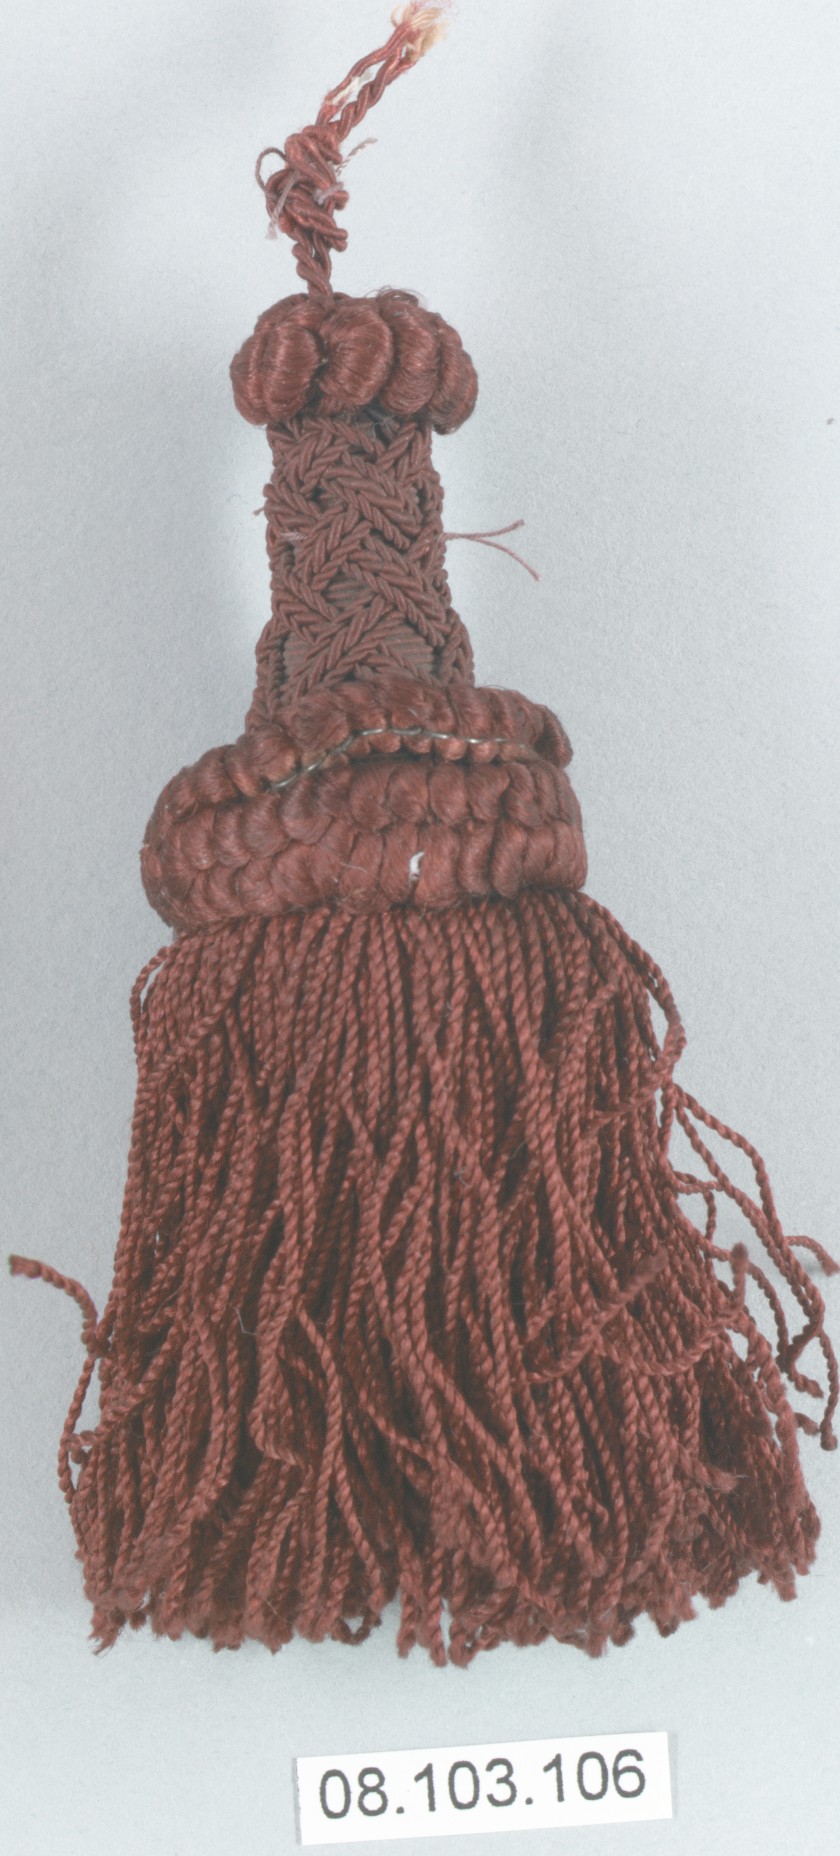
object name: tassel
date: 1701-1900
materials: silk